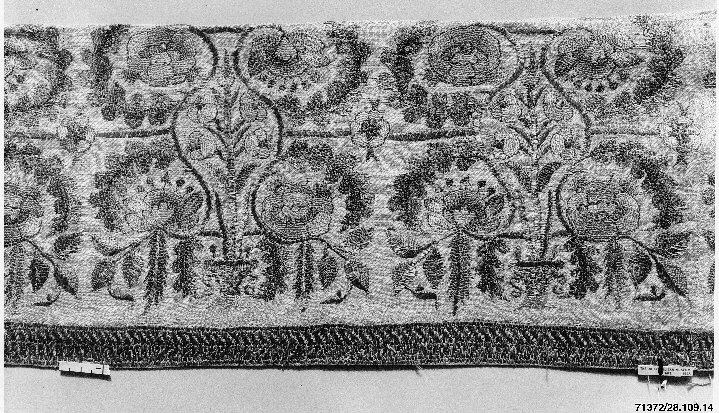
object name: strip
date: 1701-1800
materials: linen, silk, thread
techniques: embroidery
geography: turkey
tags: flowers